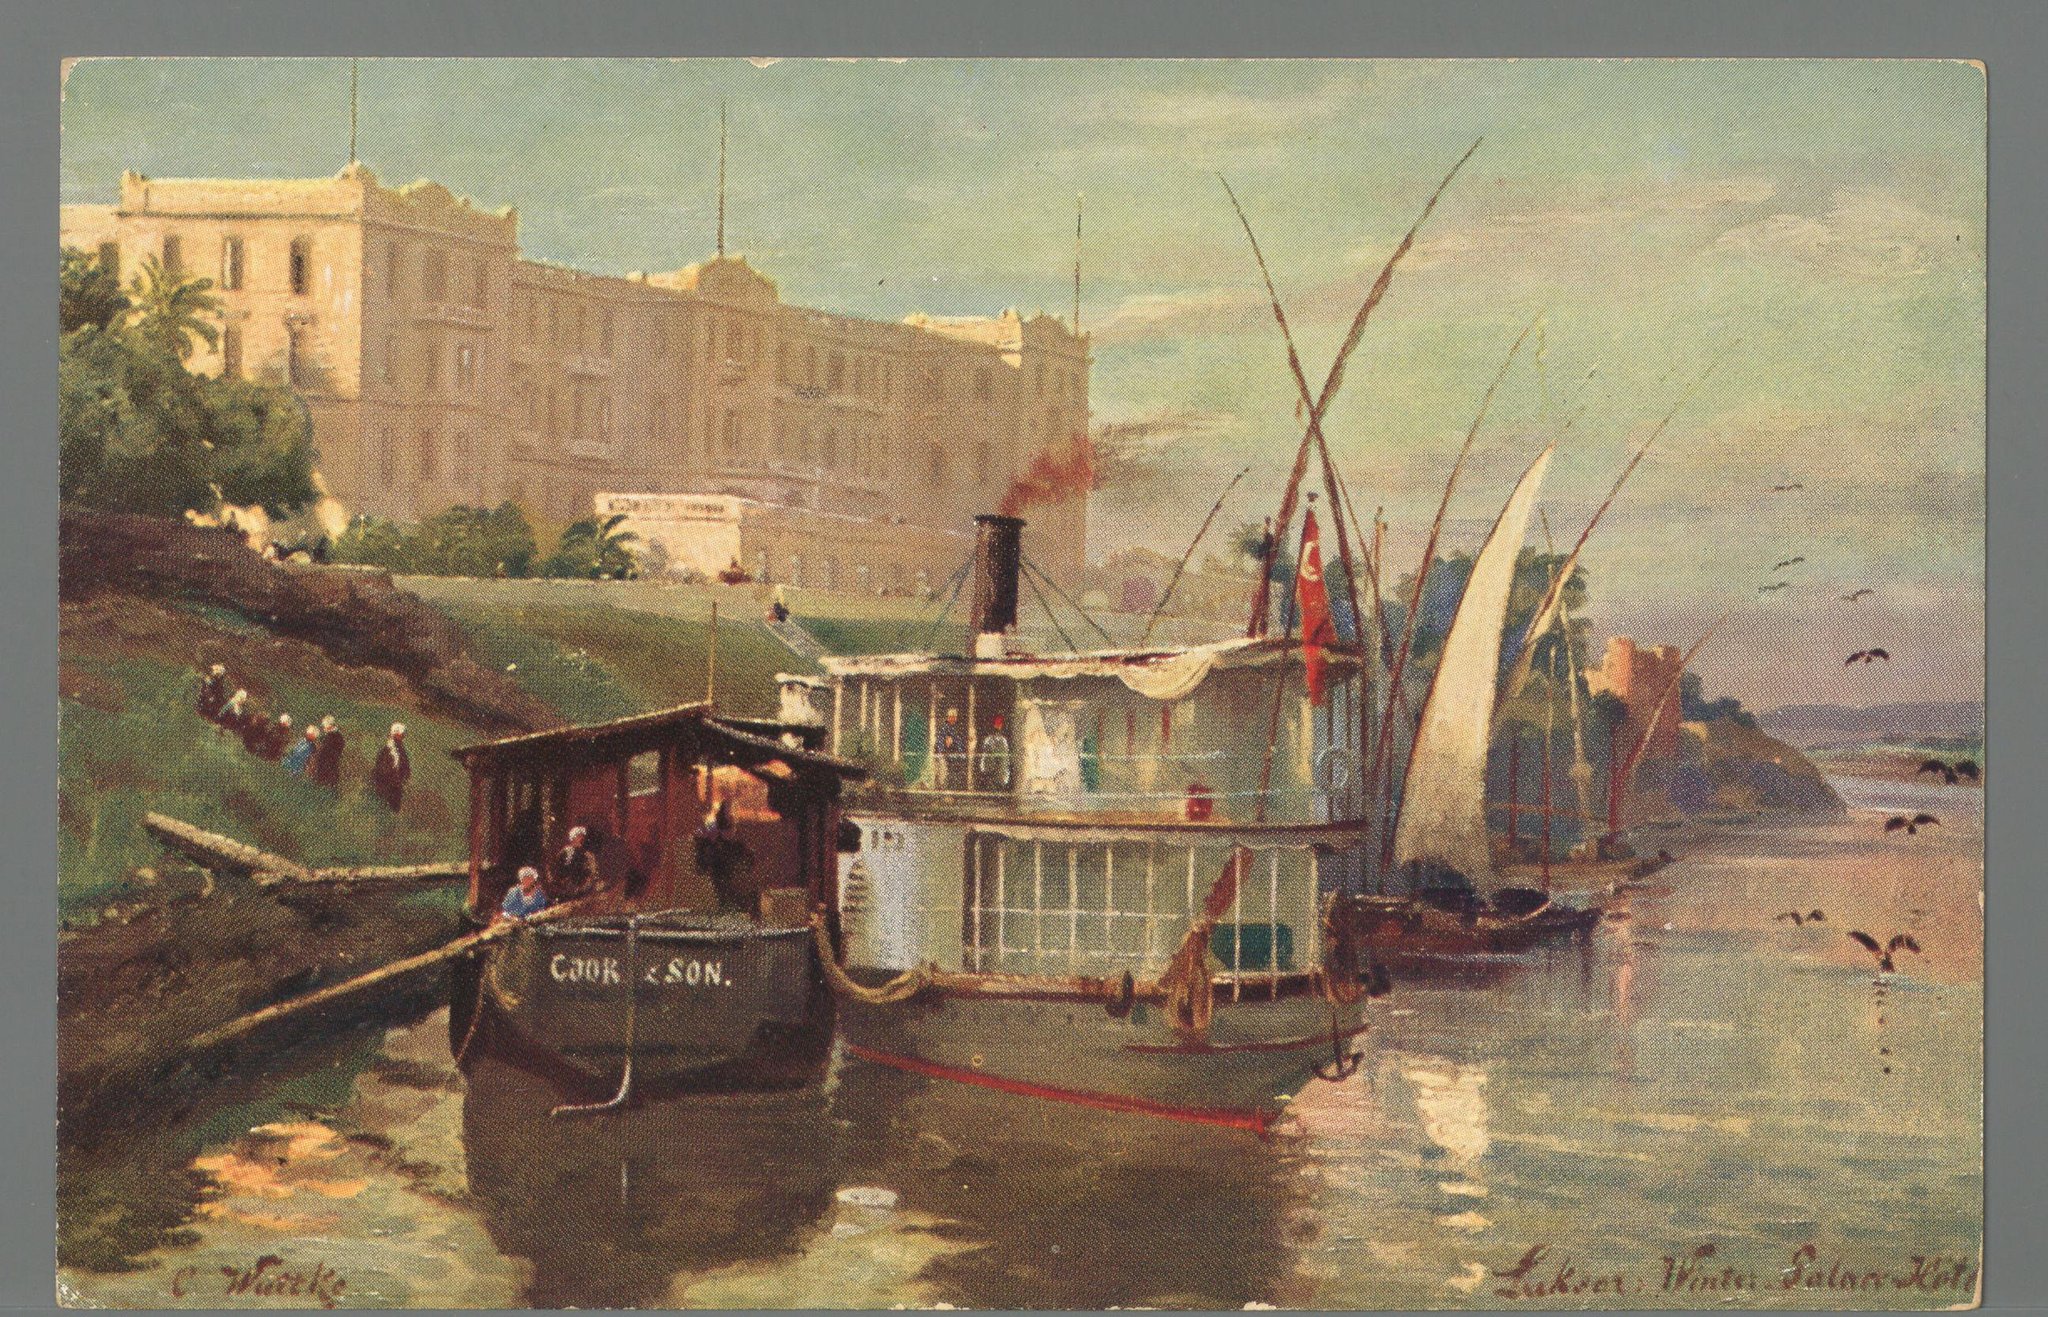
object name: ansichtkaart, prentbriefkaart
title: Luxor. Winter-Palace-Hôtel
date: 1907-1930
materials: cardboard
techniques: color autotype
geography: dresden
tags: river, hotel, hostelry, inn